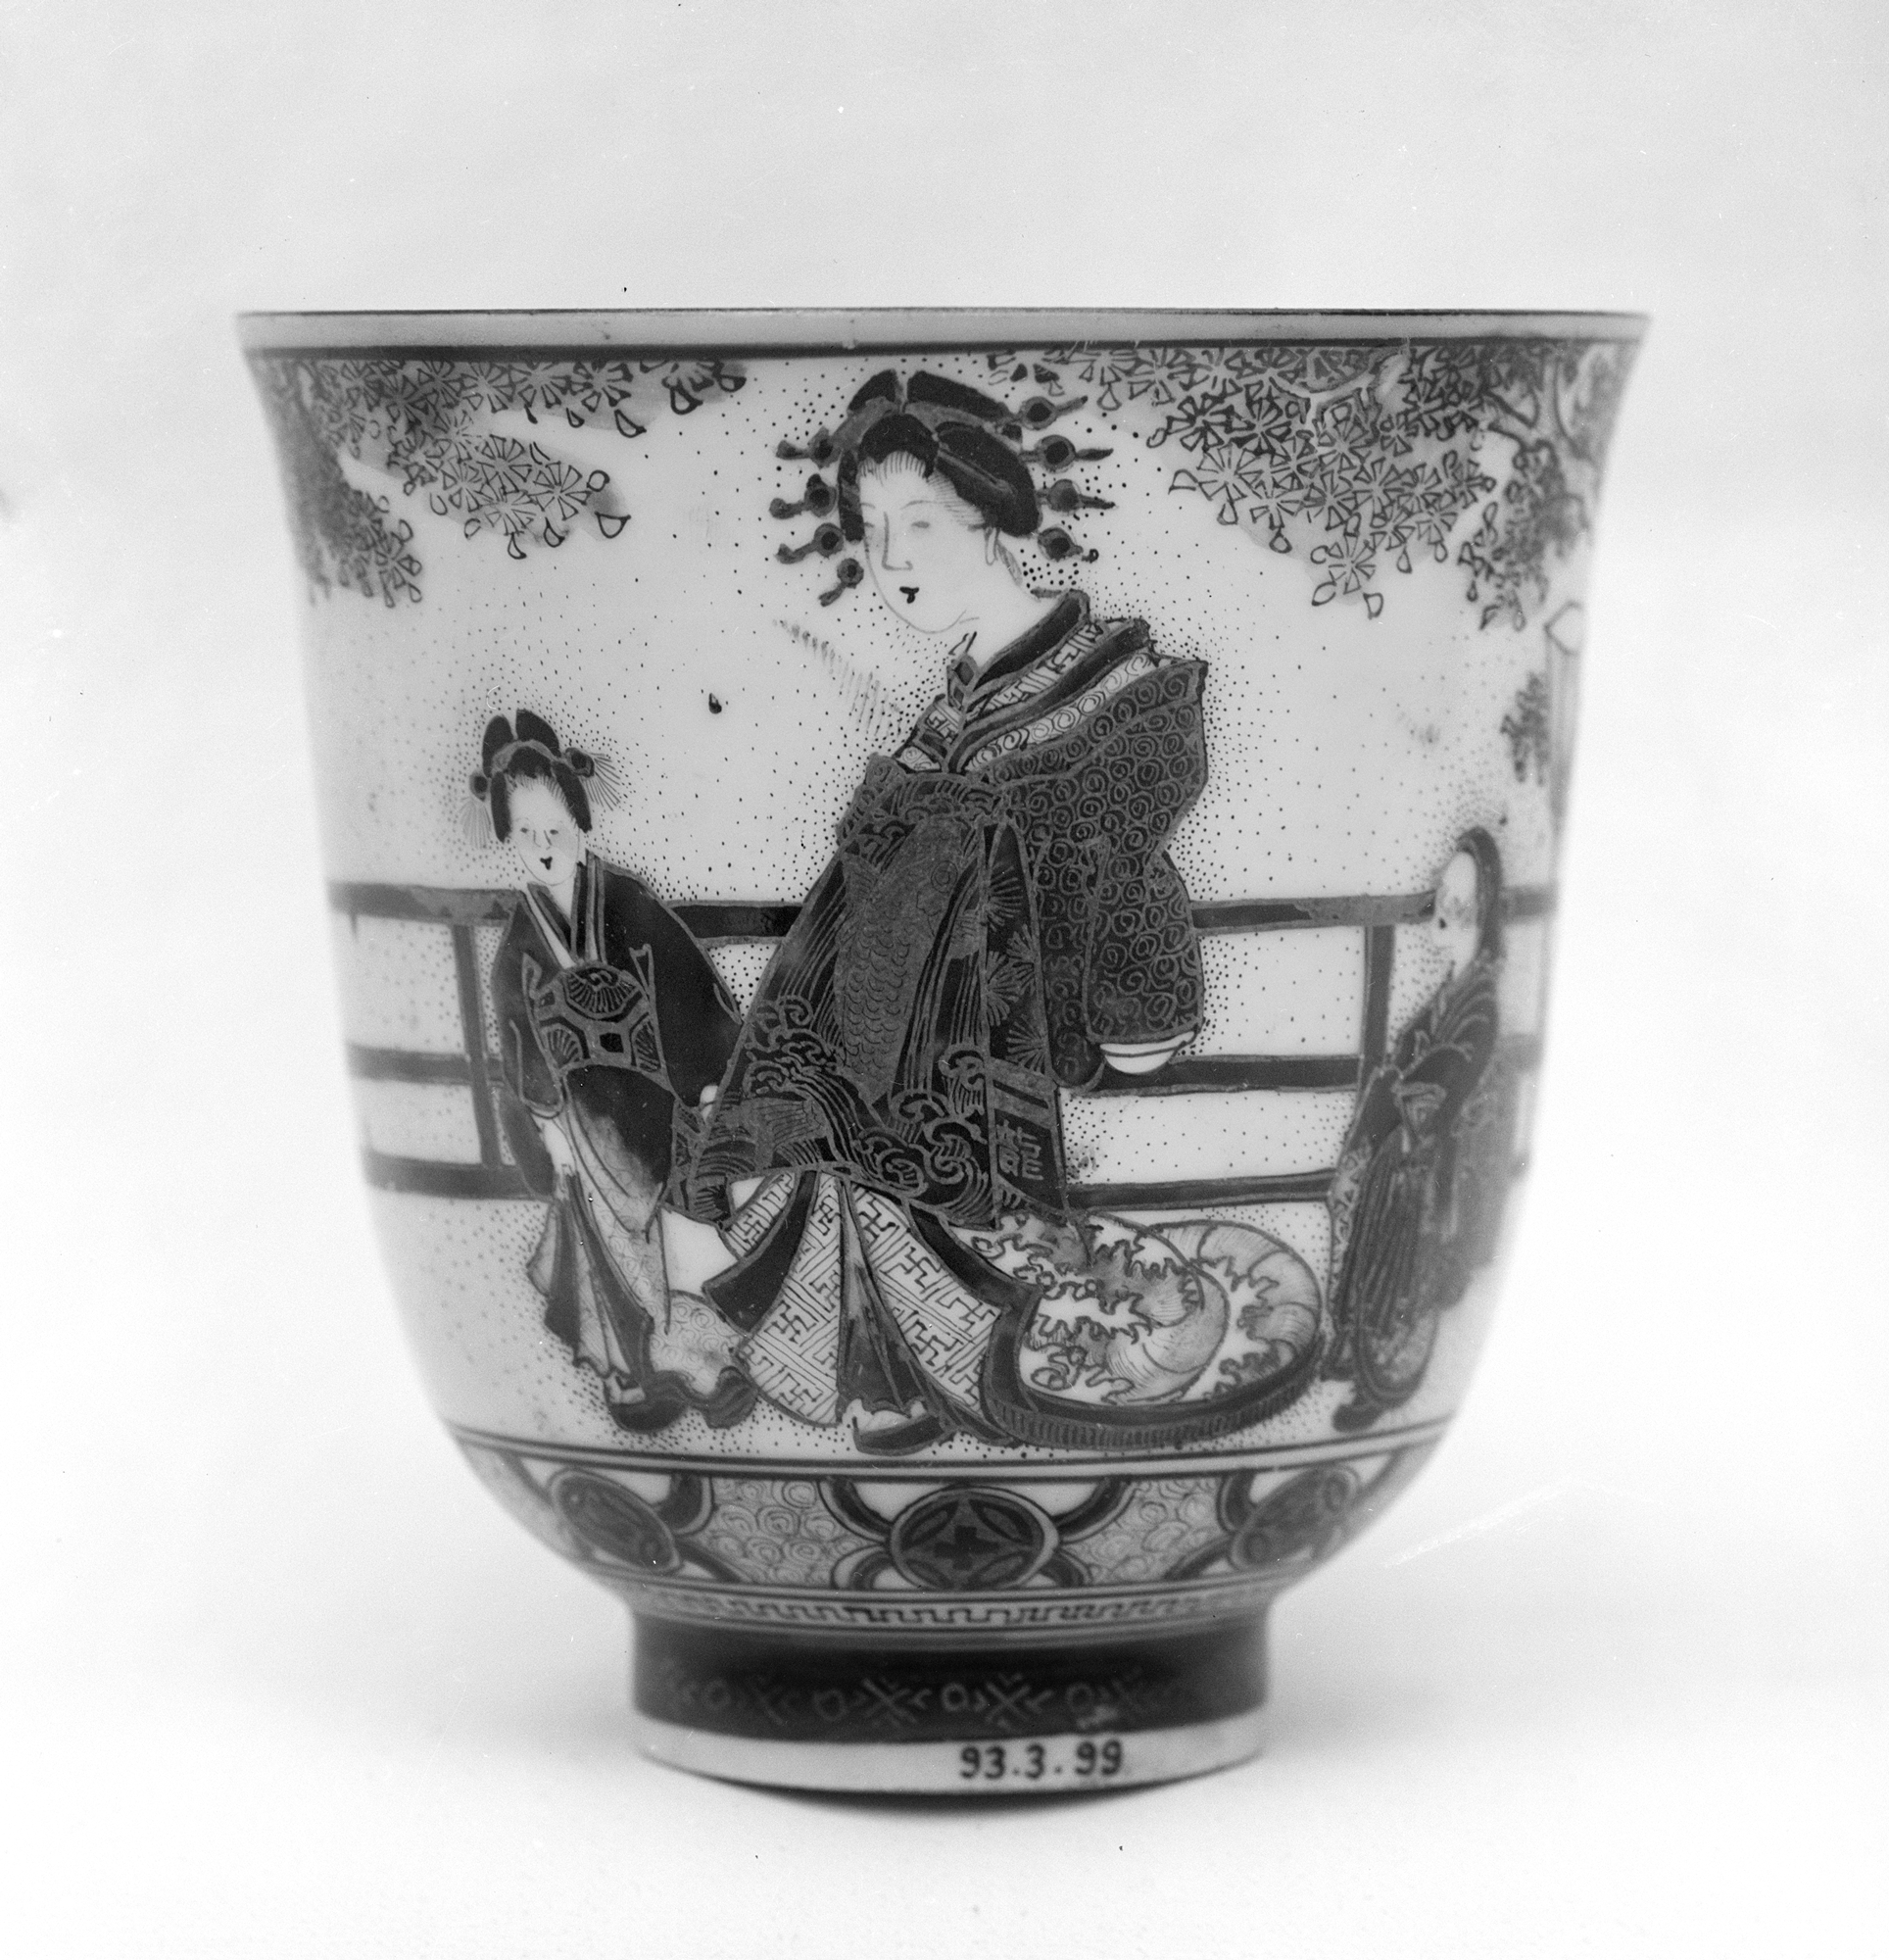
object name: cup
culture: japanese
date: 1801-1900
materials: gold, porcelain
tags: women